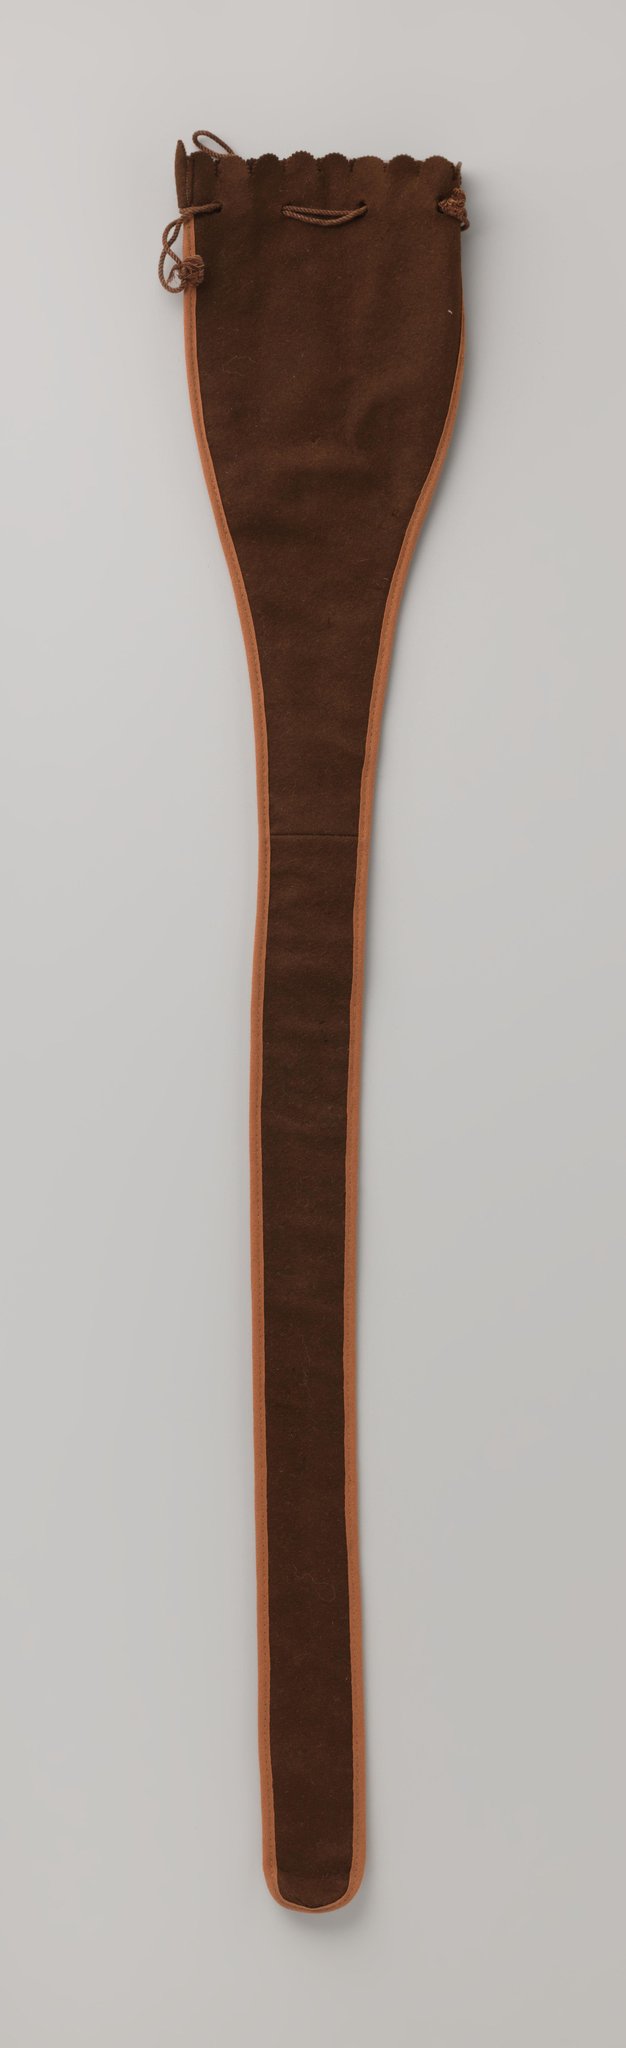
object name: case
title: Foedraal van bruin laken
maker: Anonymous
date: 1825-1850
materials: textile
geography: solingen